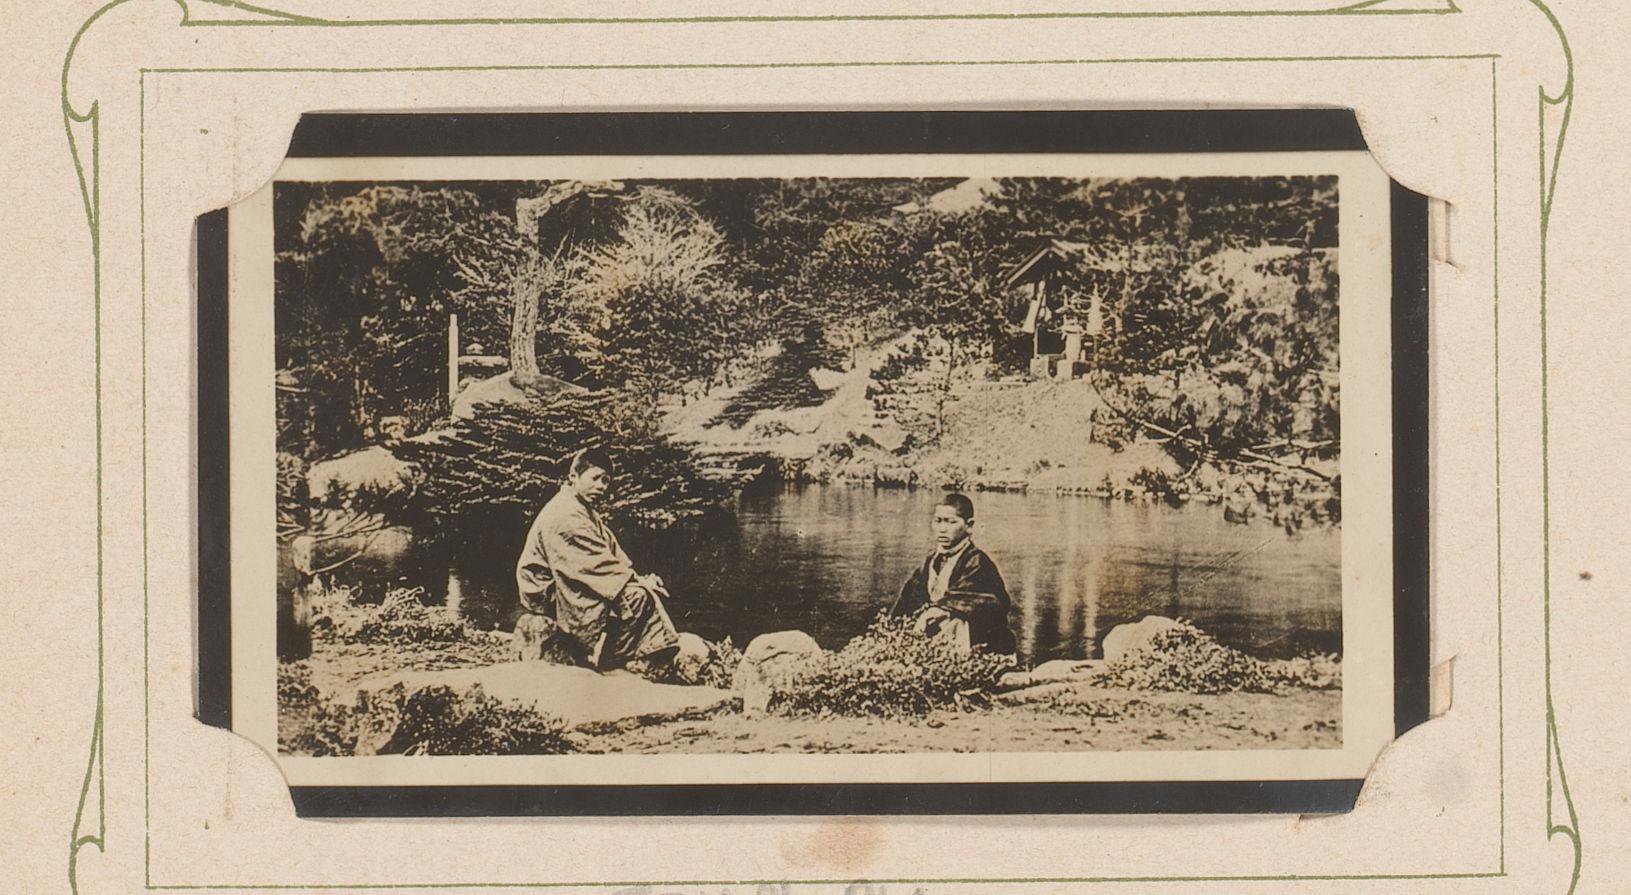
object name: album leaf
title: Twee jongens bij een vijver in Japan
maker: Anonymous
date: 1904-1905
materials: photographic support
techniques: gelatin silver print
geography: japan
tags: boy (child between toddler and youth), pond, pool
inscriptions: inscription: ‘No. 5./ Buitenplaats te Nikko’